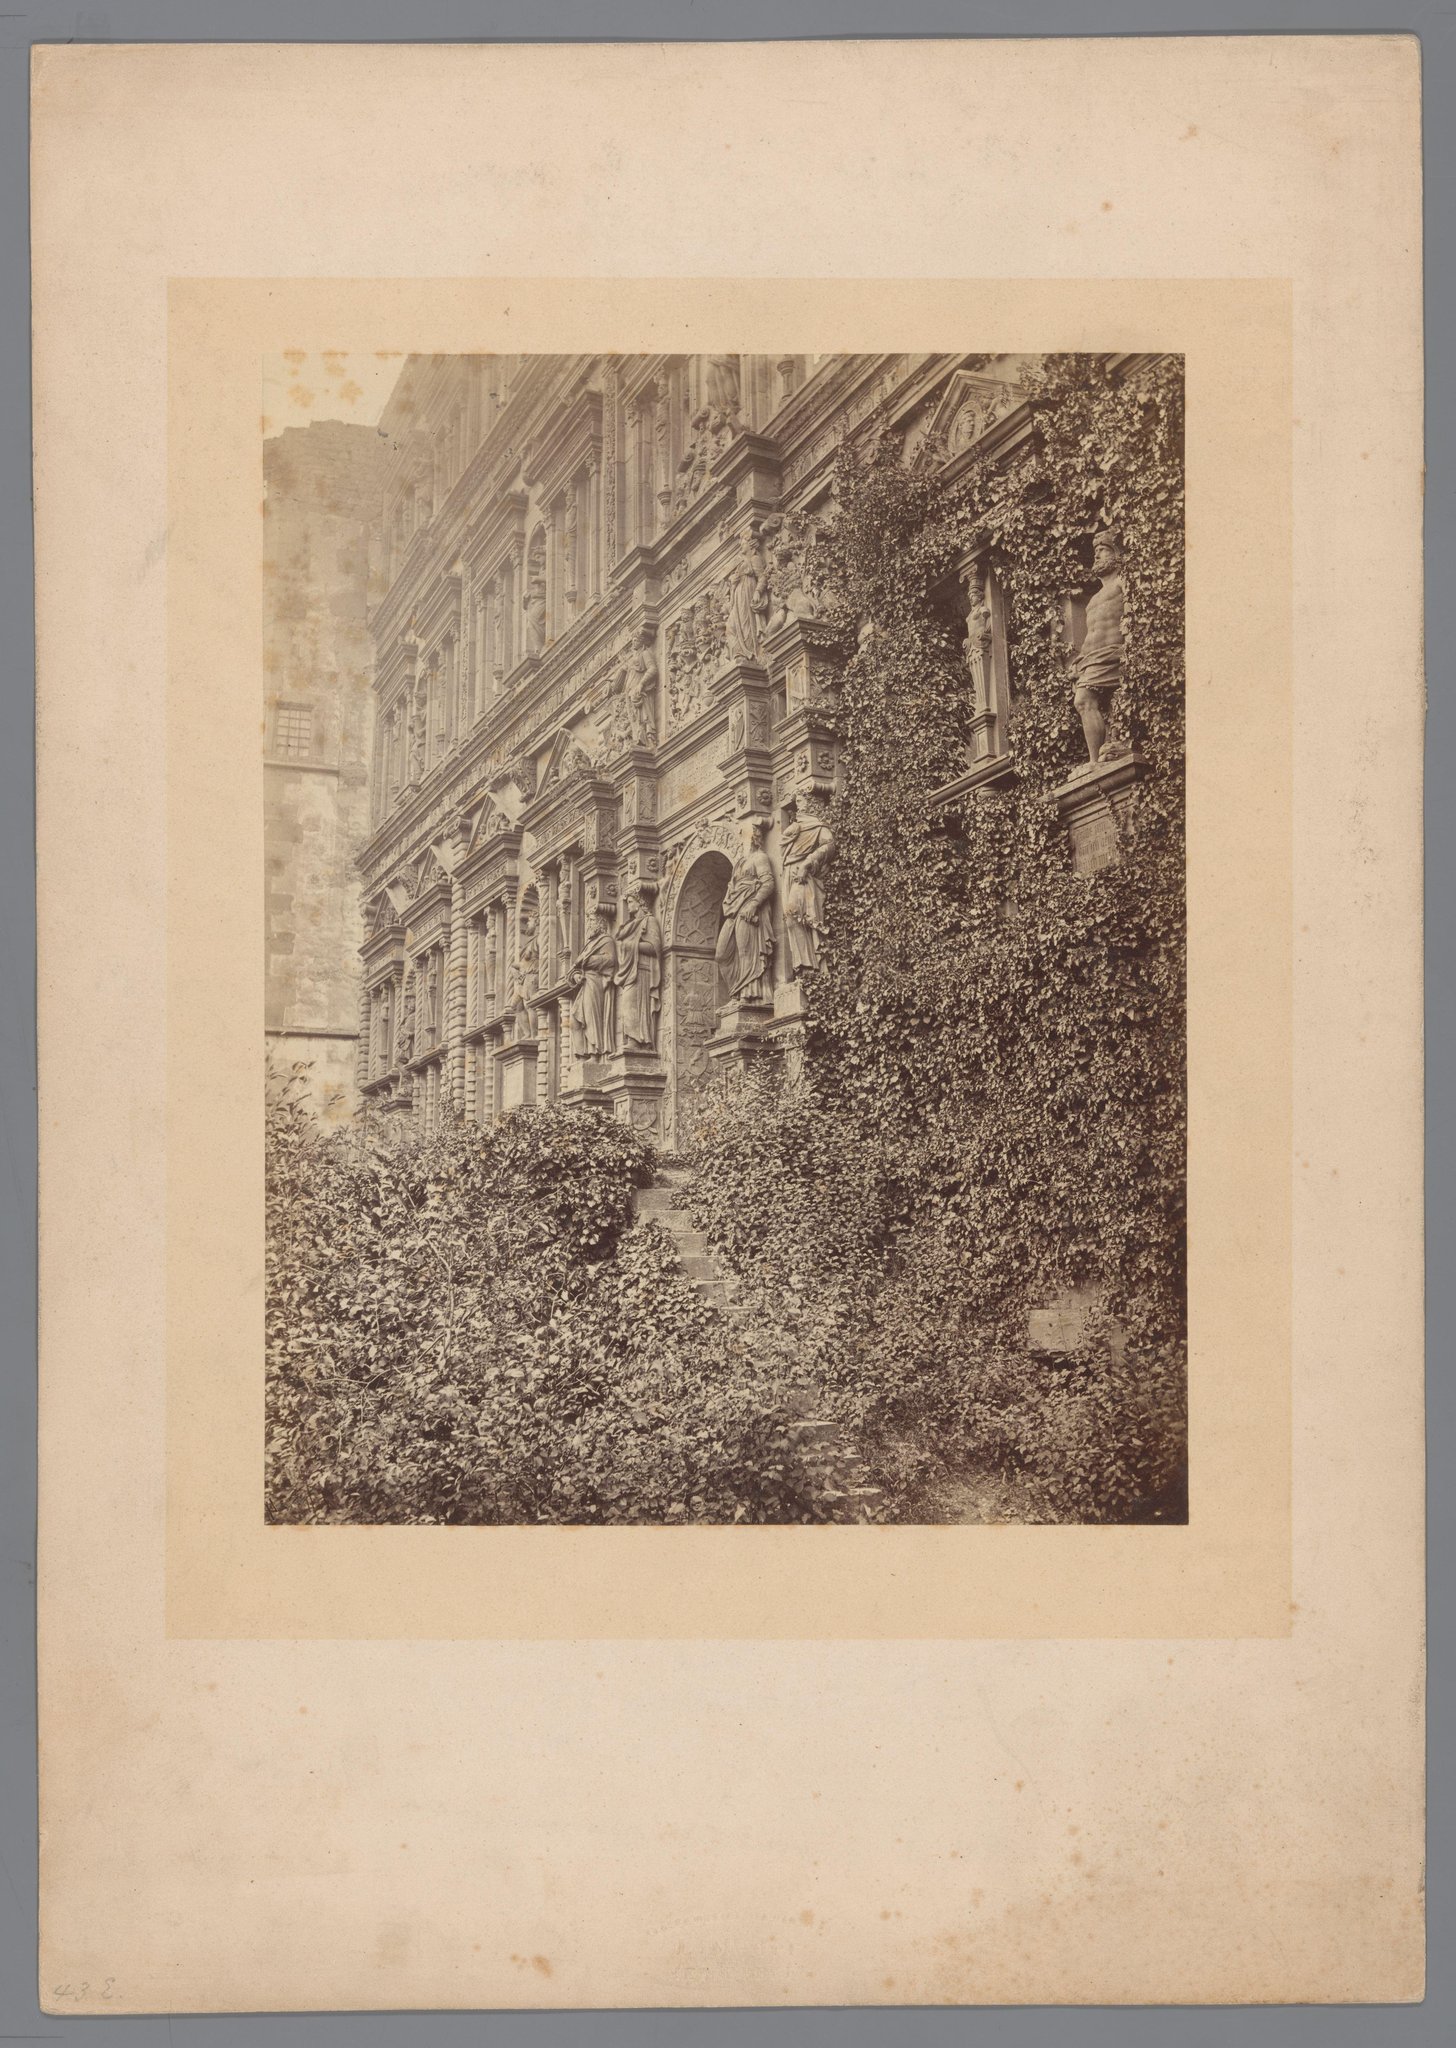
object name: photograph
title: Façade van een gebouw begroeid met klimplanten en gedecoreerd met sculpturen van mannen en vrouwen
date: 1875-1900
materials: cardboard, photographic support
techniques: albumen print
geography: heidelberg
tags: ornamental fountain, plants and herbs: ivy, europe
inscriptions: collector's mark: Lugt 3937, number: ‘43 E.’